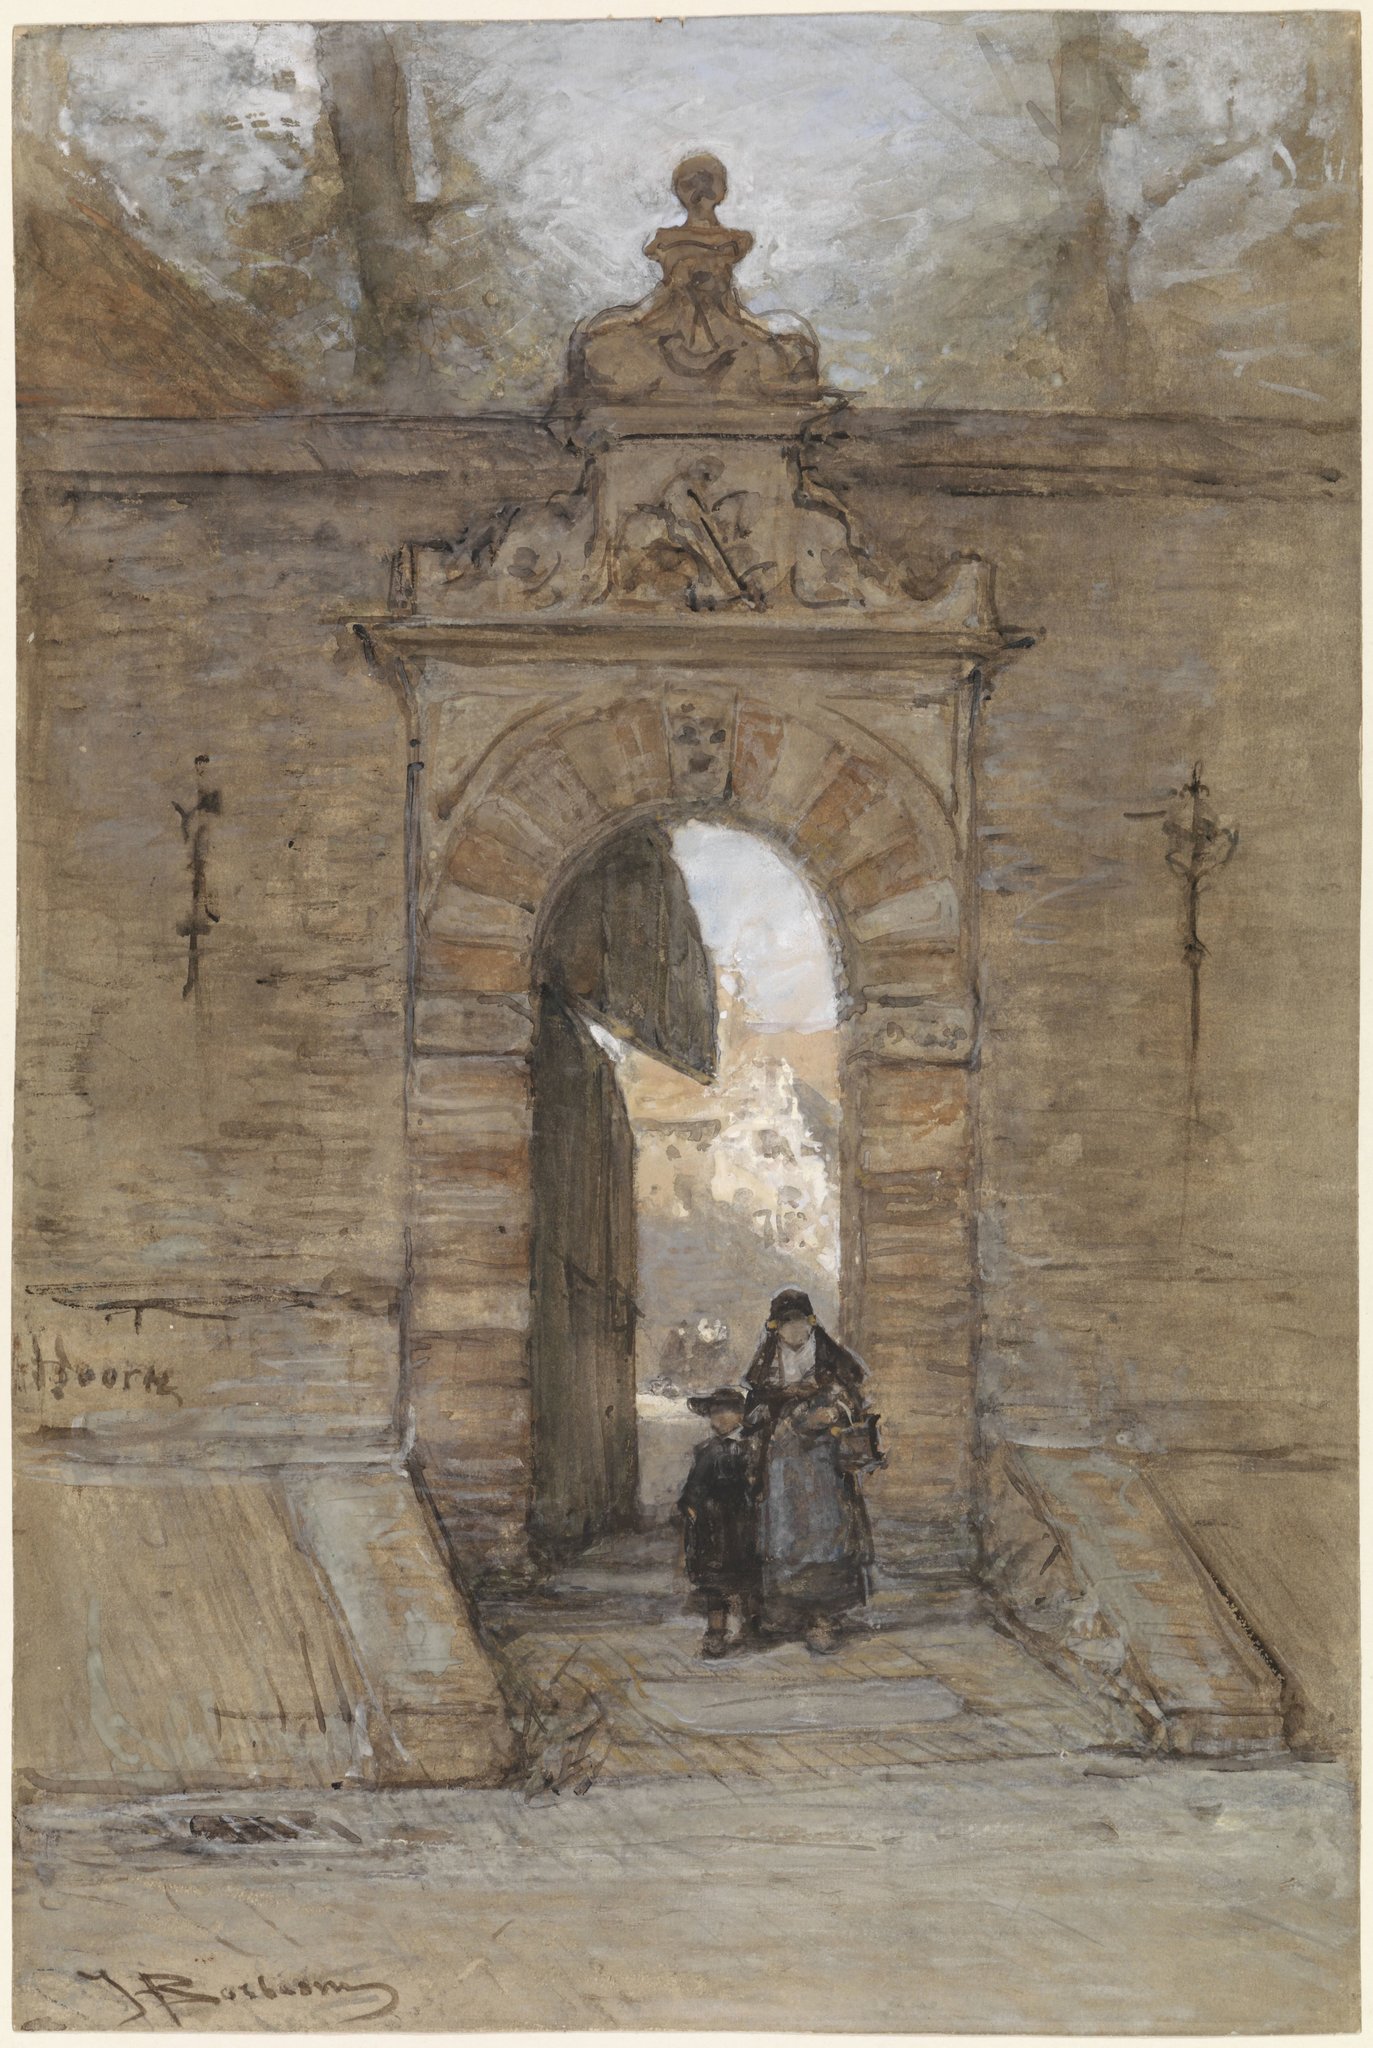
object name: watercolor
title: Sint-Jorispoort in het Doelengebouw te Hoorn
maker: johannes bosboom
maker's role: draughtsman, painter, print maker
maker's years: 1817-1891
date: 1827-1891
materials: paint, paper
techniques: brush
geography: netherlands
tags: city-gate, hoorn (north holland)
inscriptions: annotation: ‘Hoorn’, signature: ‘J Bosboom’